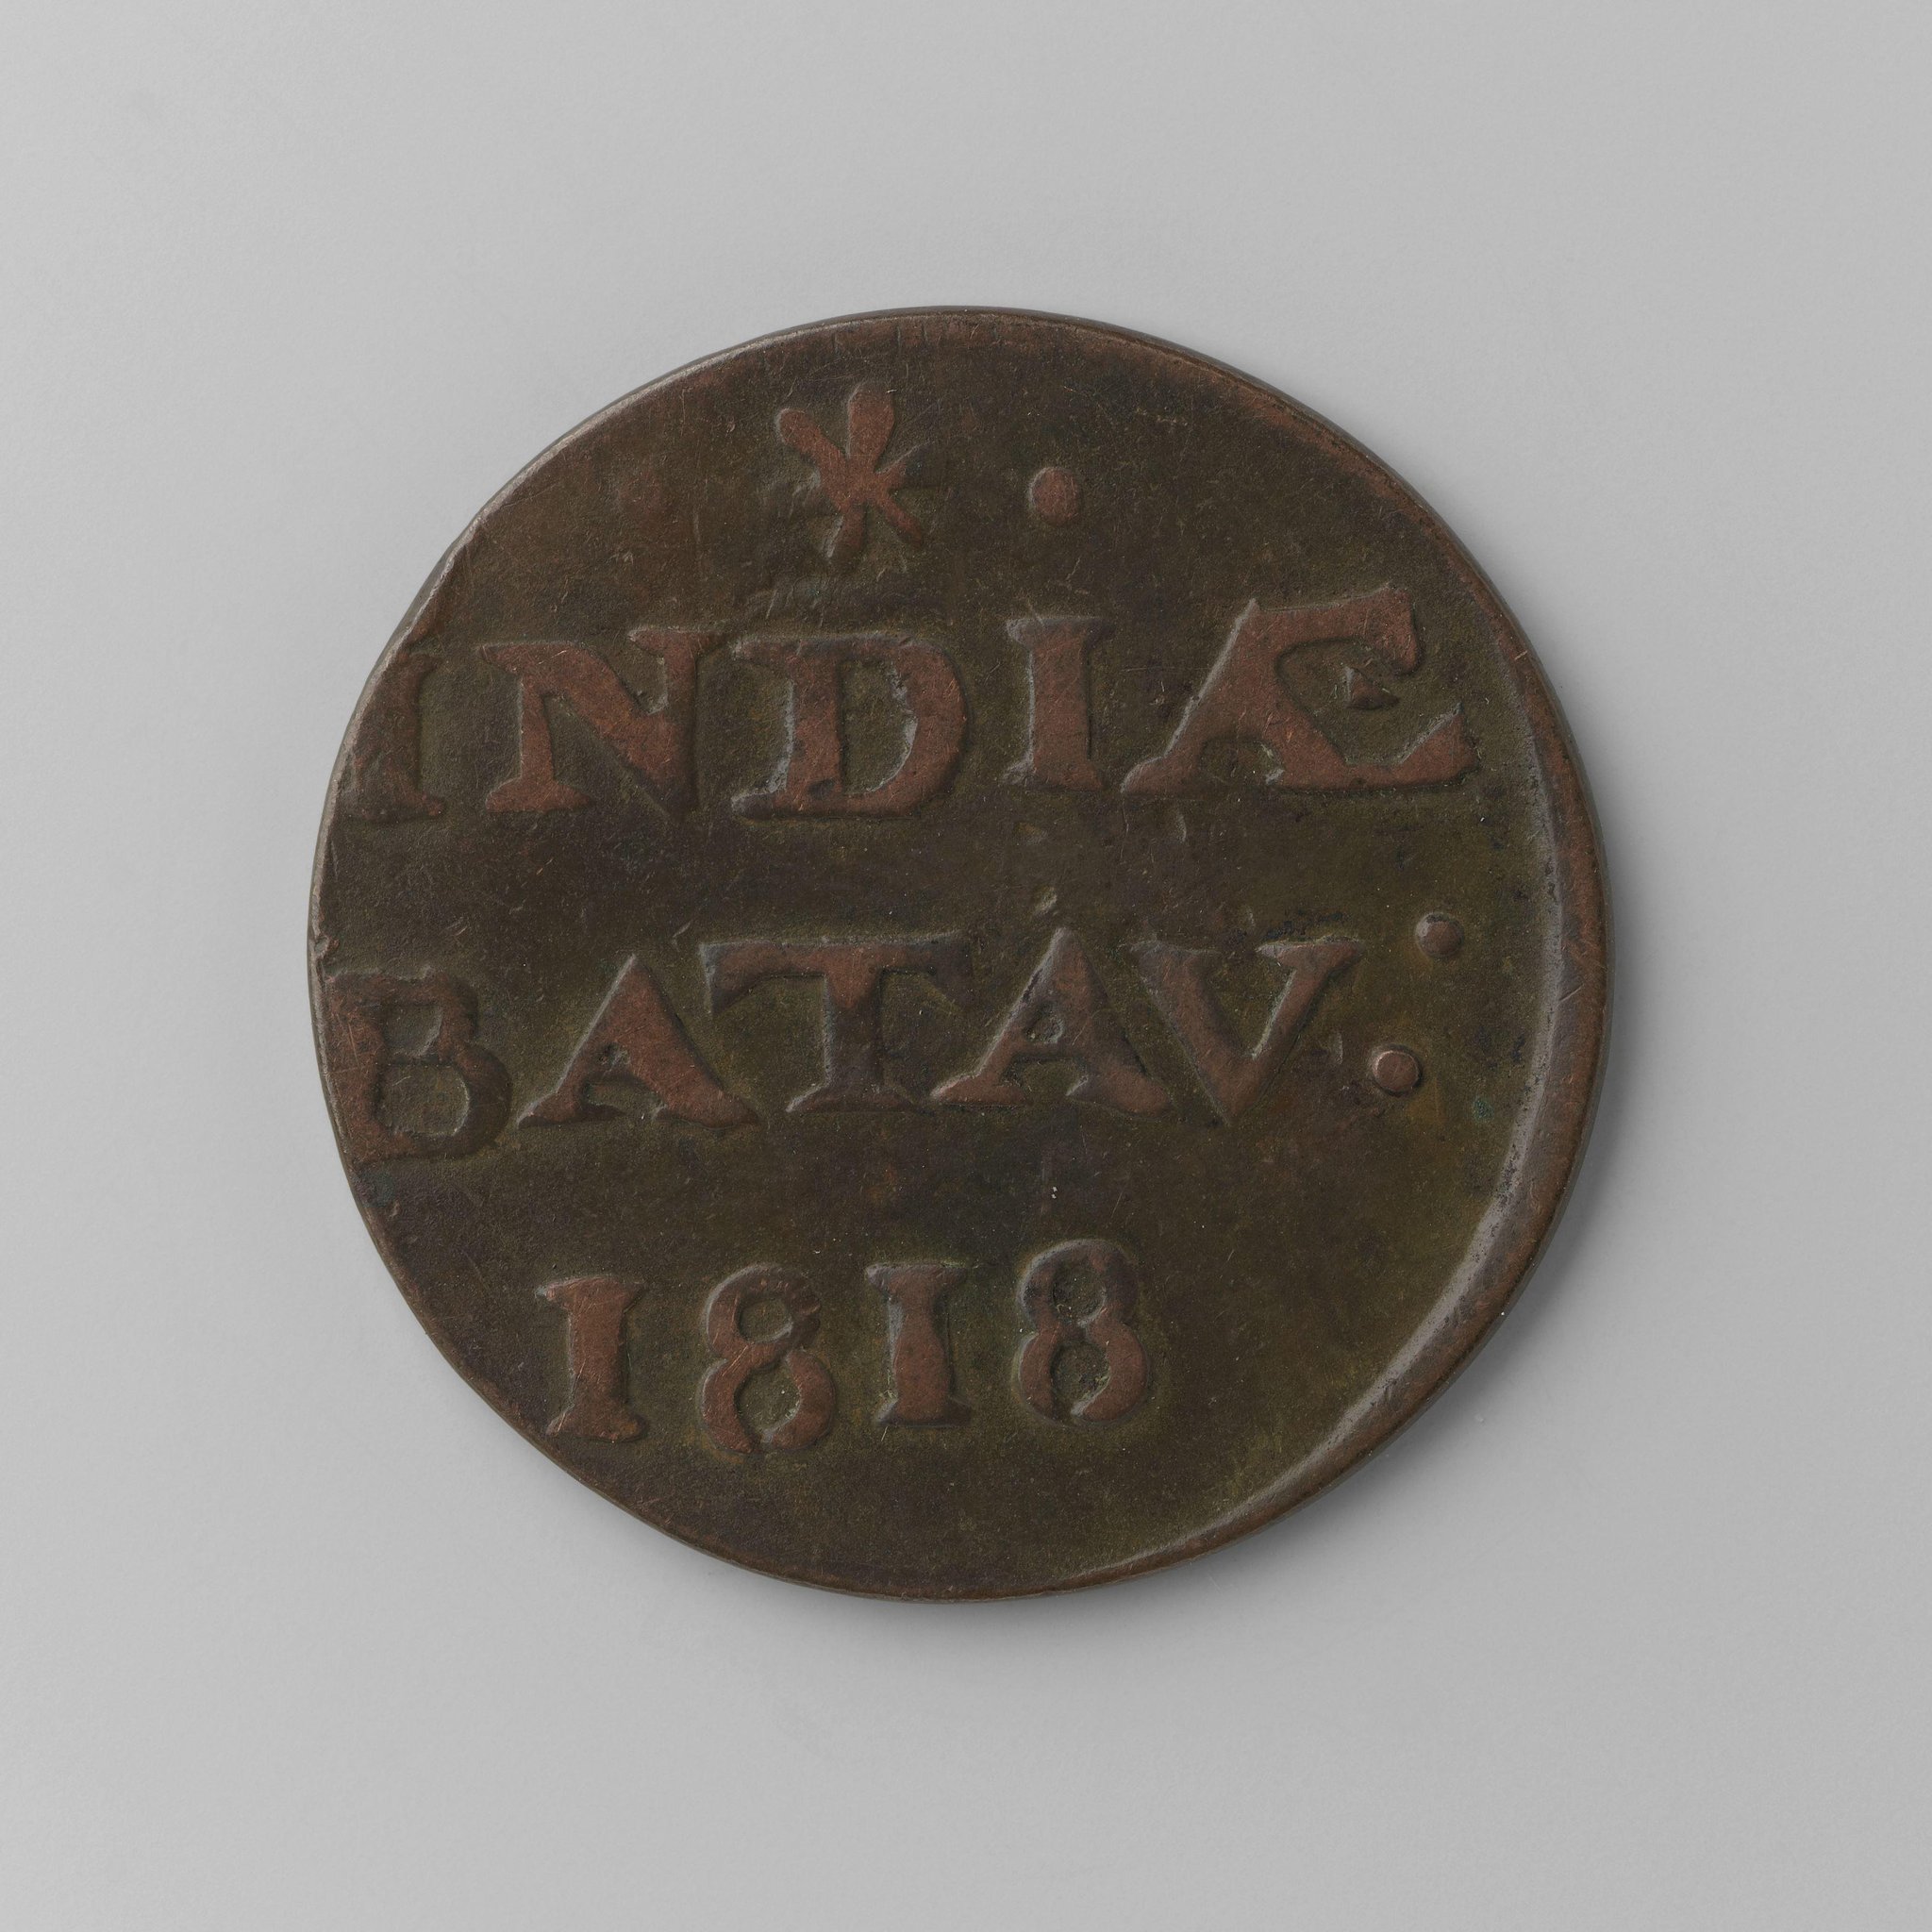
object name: coin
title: Duit van Nederlands Indië,1818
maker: william i of the netherlands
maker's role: koning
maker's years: 1772-1843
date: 1818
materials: copper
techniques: striking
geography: surabaya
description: Koperen munt. Voorzijde: tussen waarde-aanduiding 5 1/16 G. gekroond generaliteitswapenschild. Keerzijde: tweeregelig opschrift, waarboven muntteken en waaronder jaartal. Gladde rand.